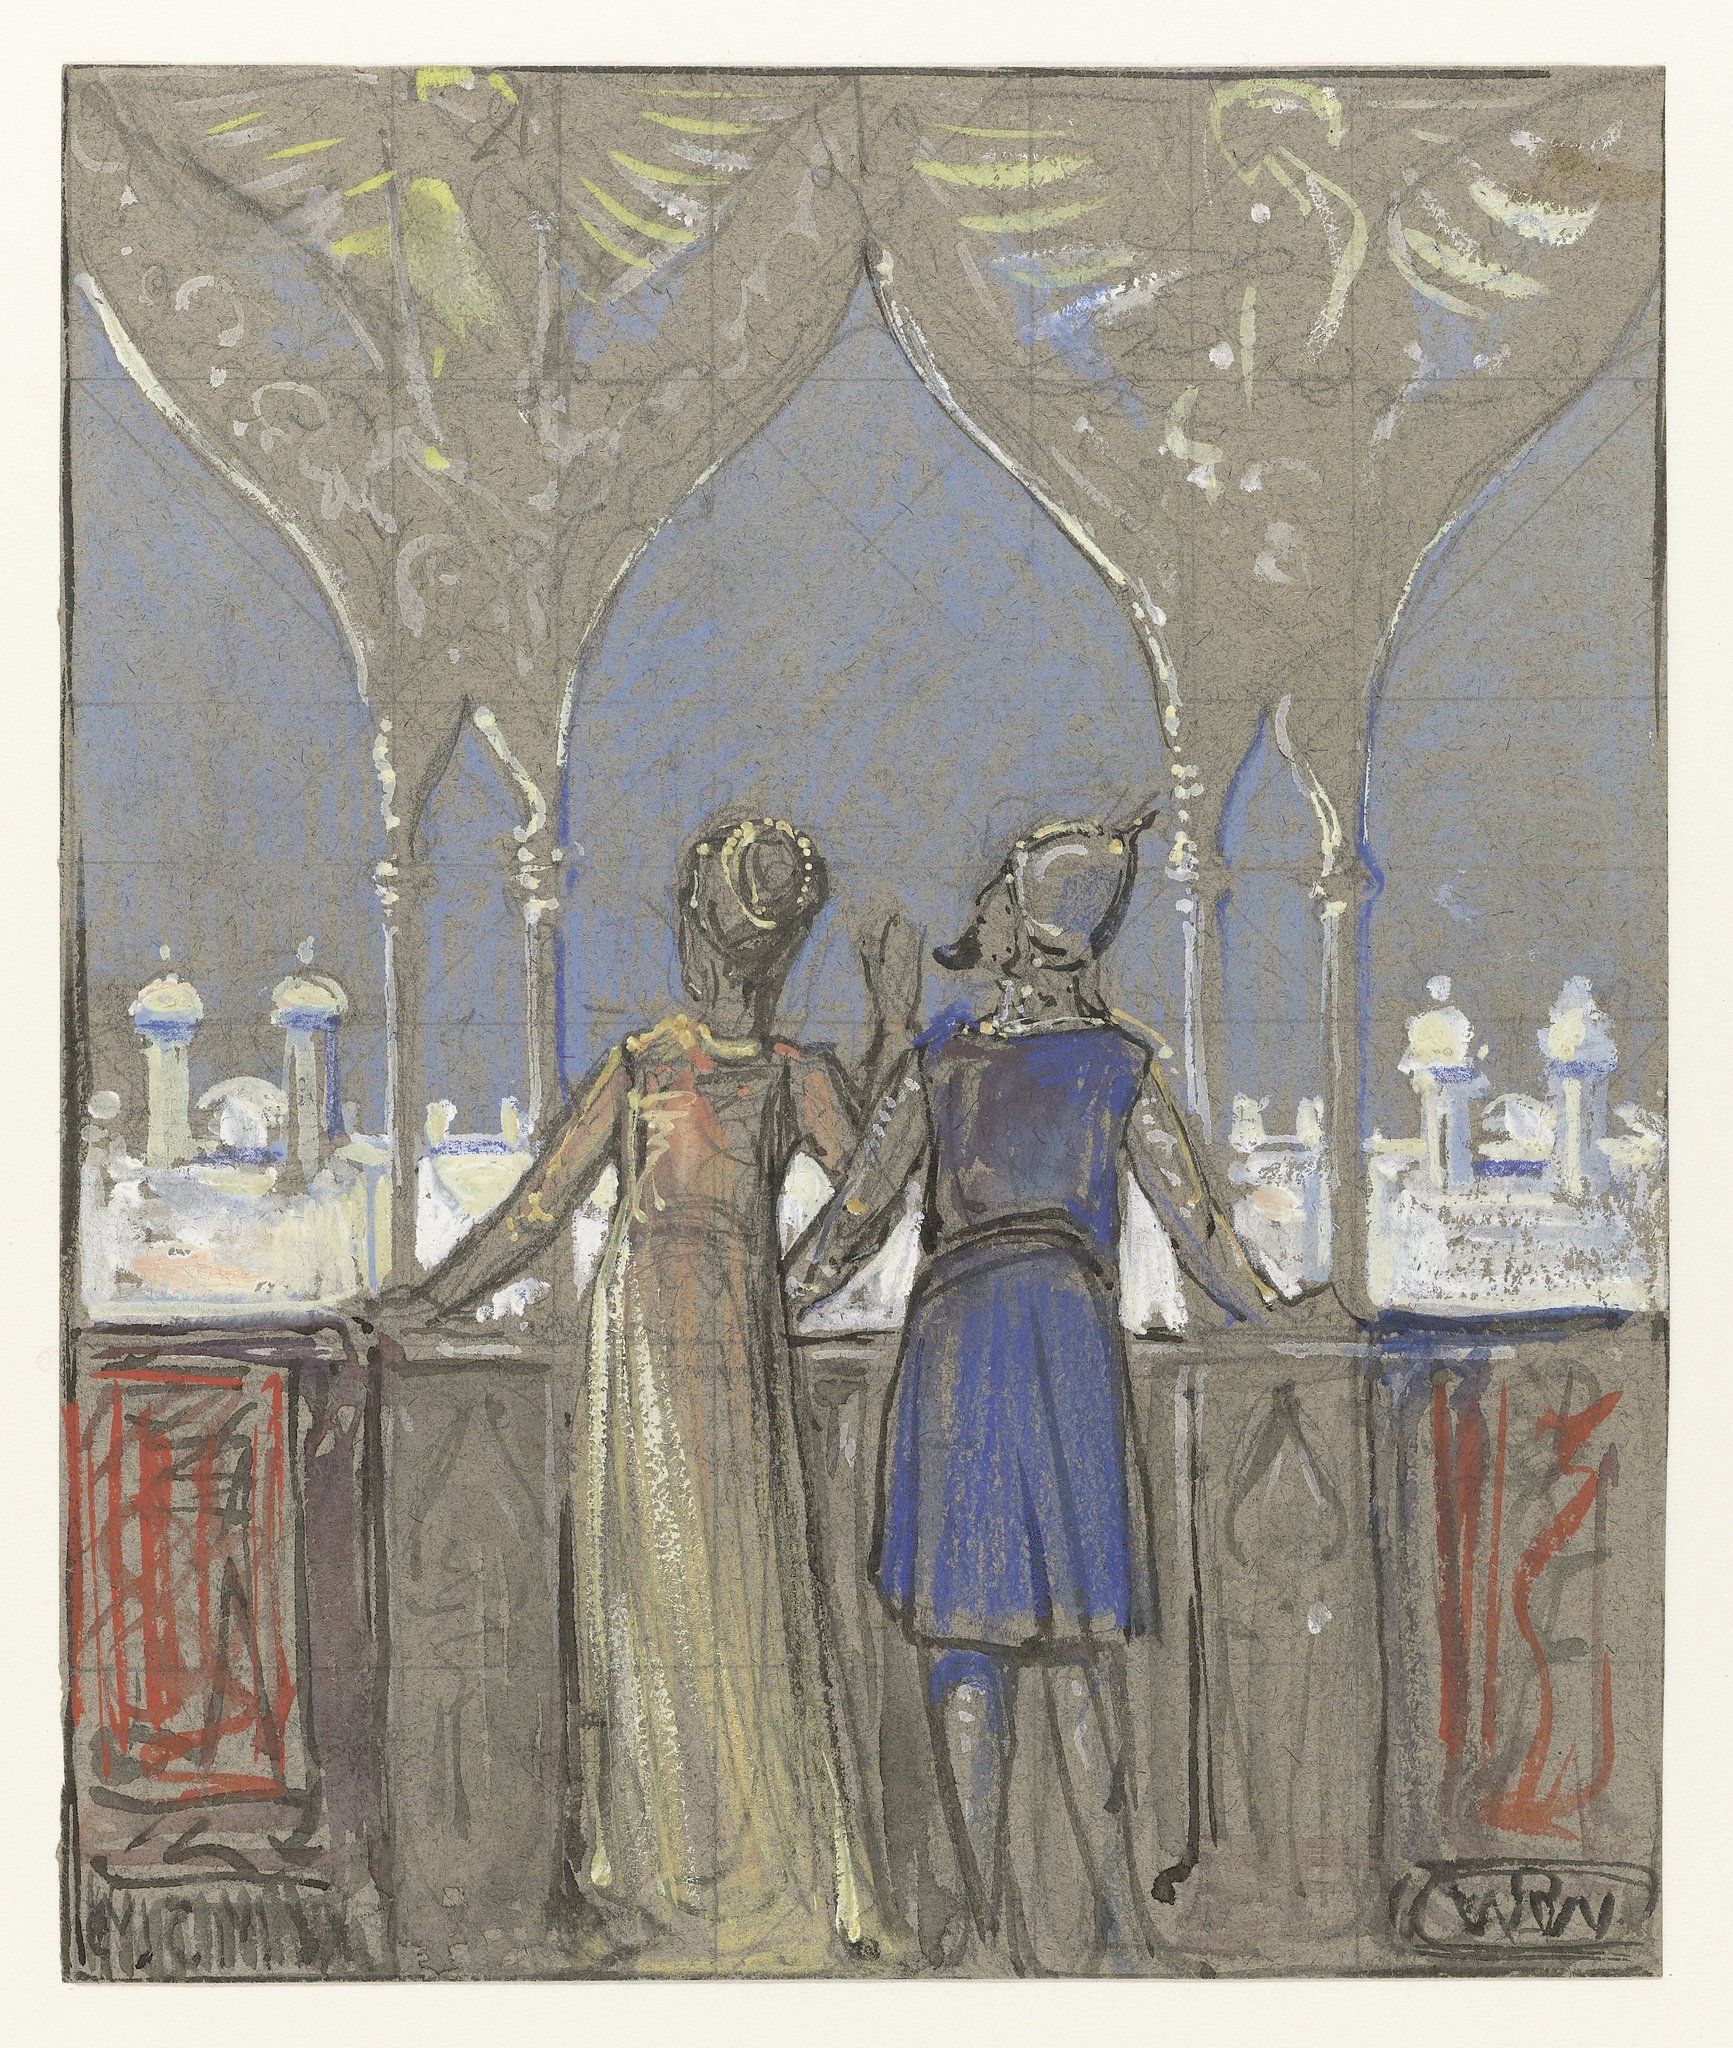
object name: drawing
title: Paar uitkijkend over oosterse stad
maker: bernard willem wierink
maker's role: draughtsman, print maker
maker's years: 1856-1939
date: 1908-1937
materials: paint, paper, pencil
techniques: brush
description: Staande man en vrouw, op de rug gezien, en gekleed in Romeinse (?) kleding, voor een balustrade uitkijkend over een oosterse stad. De man draagt een helm. In map met 31 ontwerptekeningen en schetsen voor illustraties.